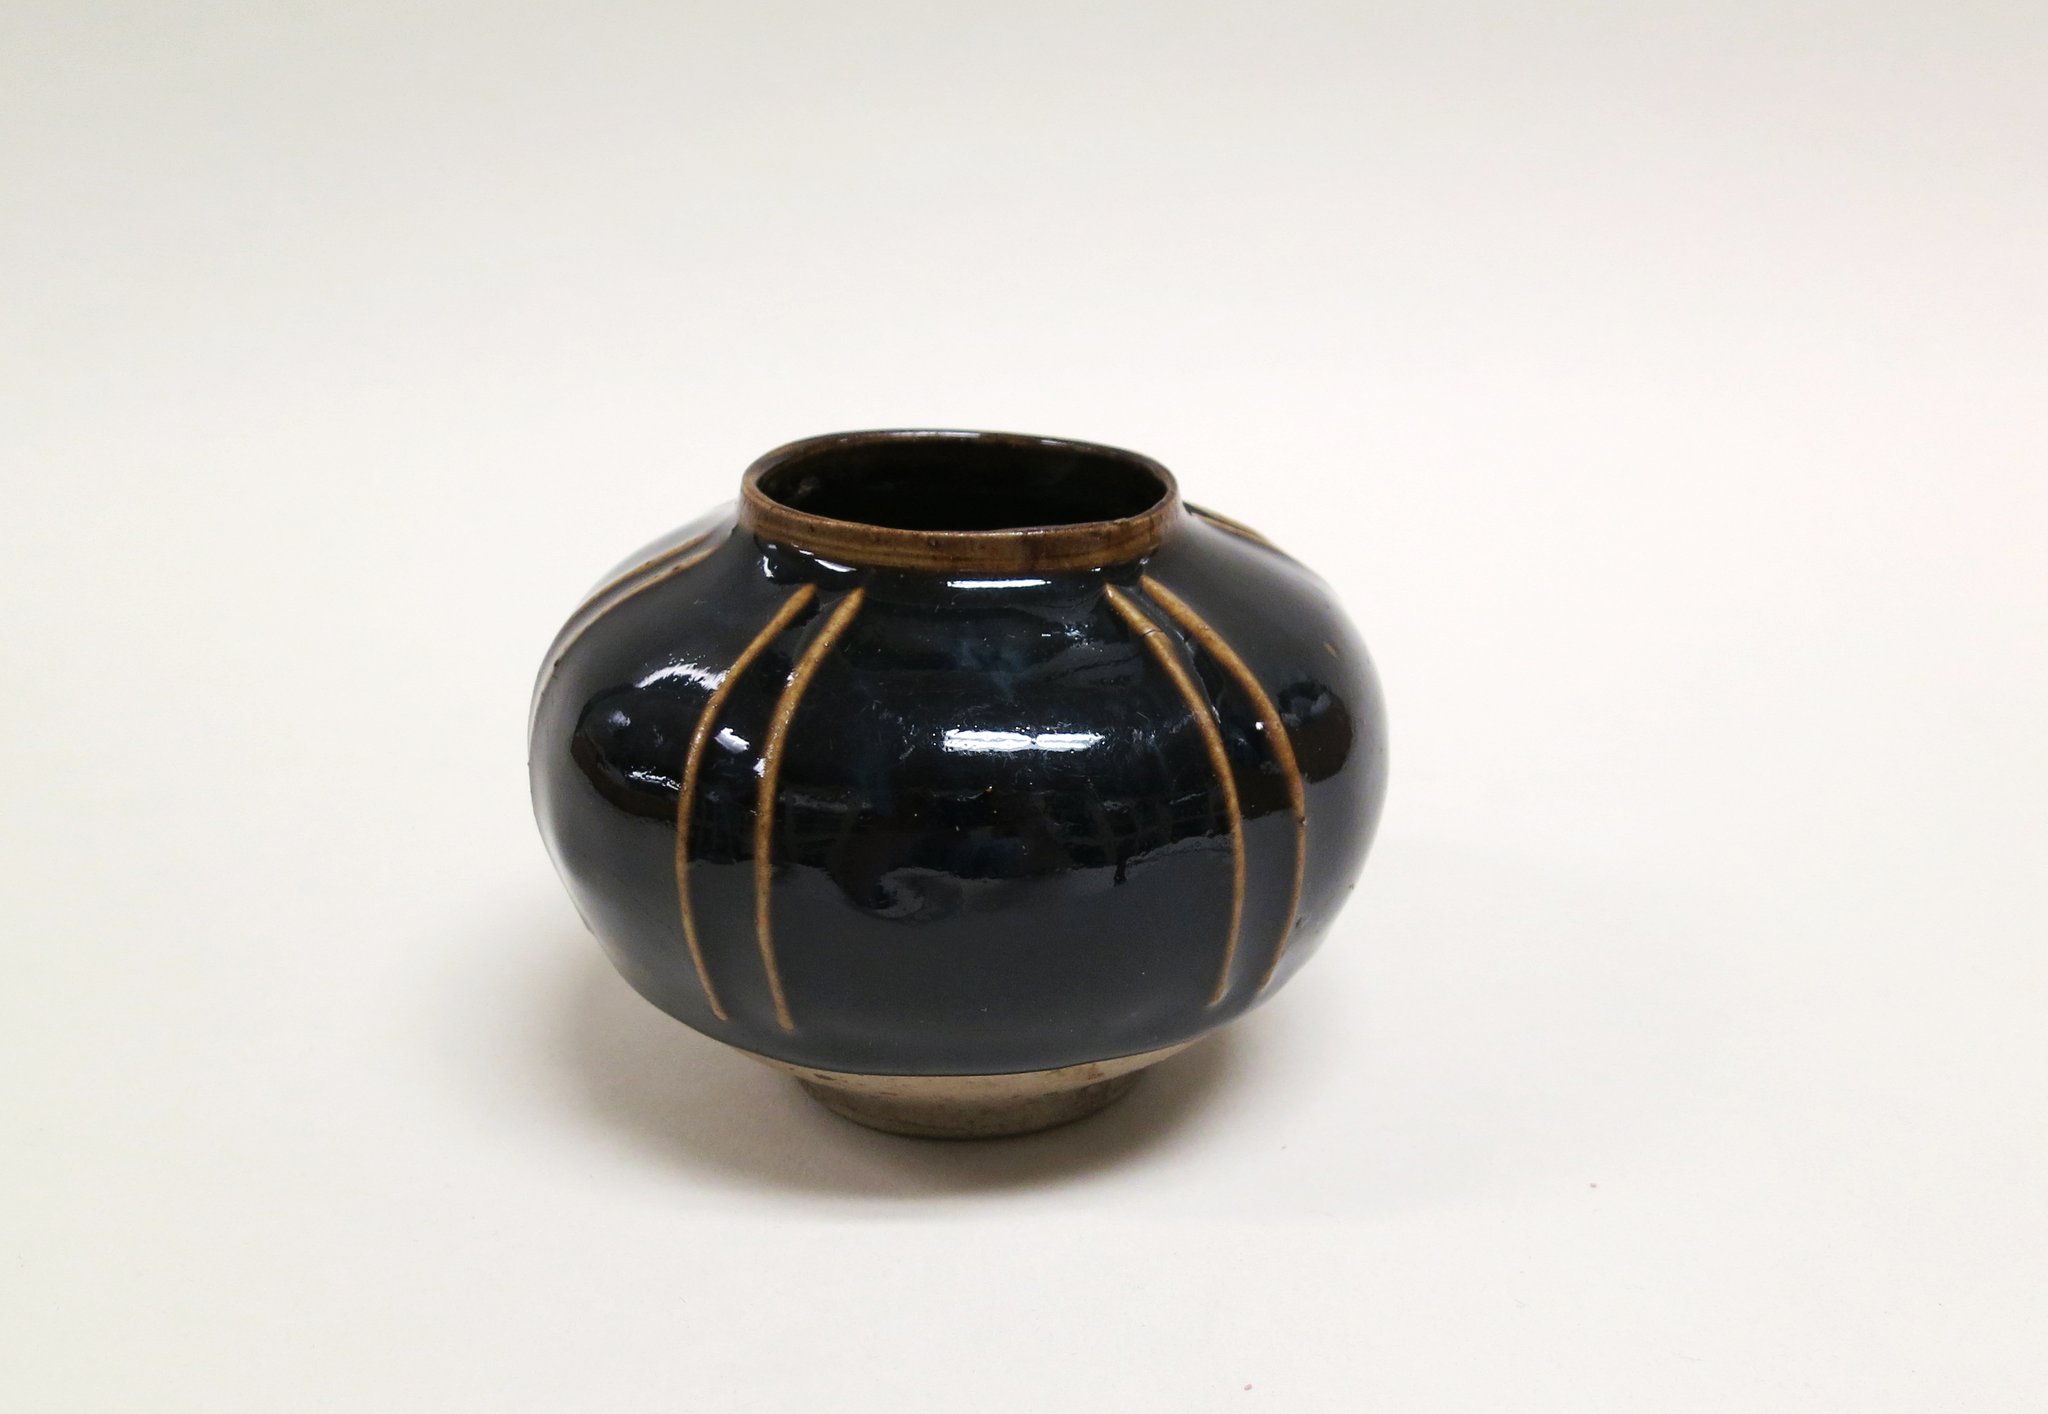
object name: jar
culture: chinese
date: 960-1127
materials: glaze, stoneware